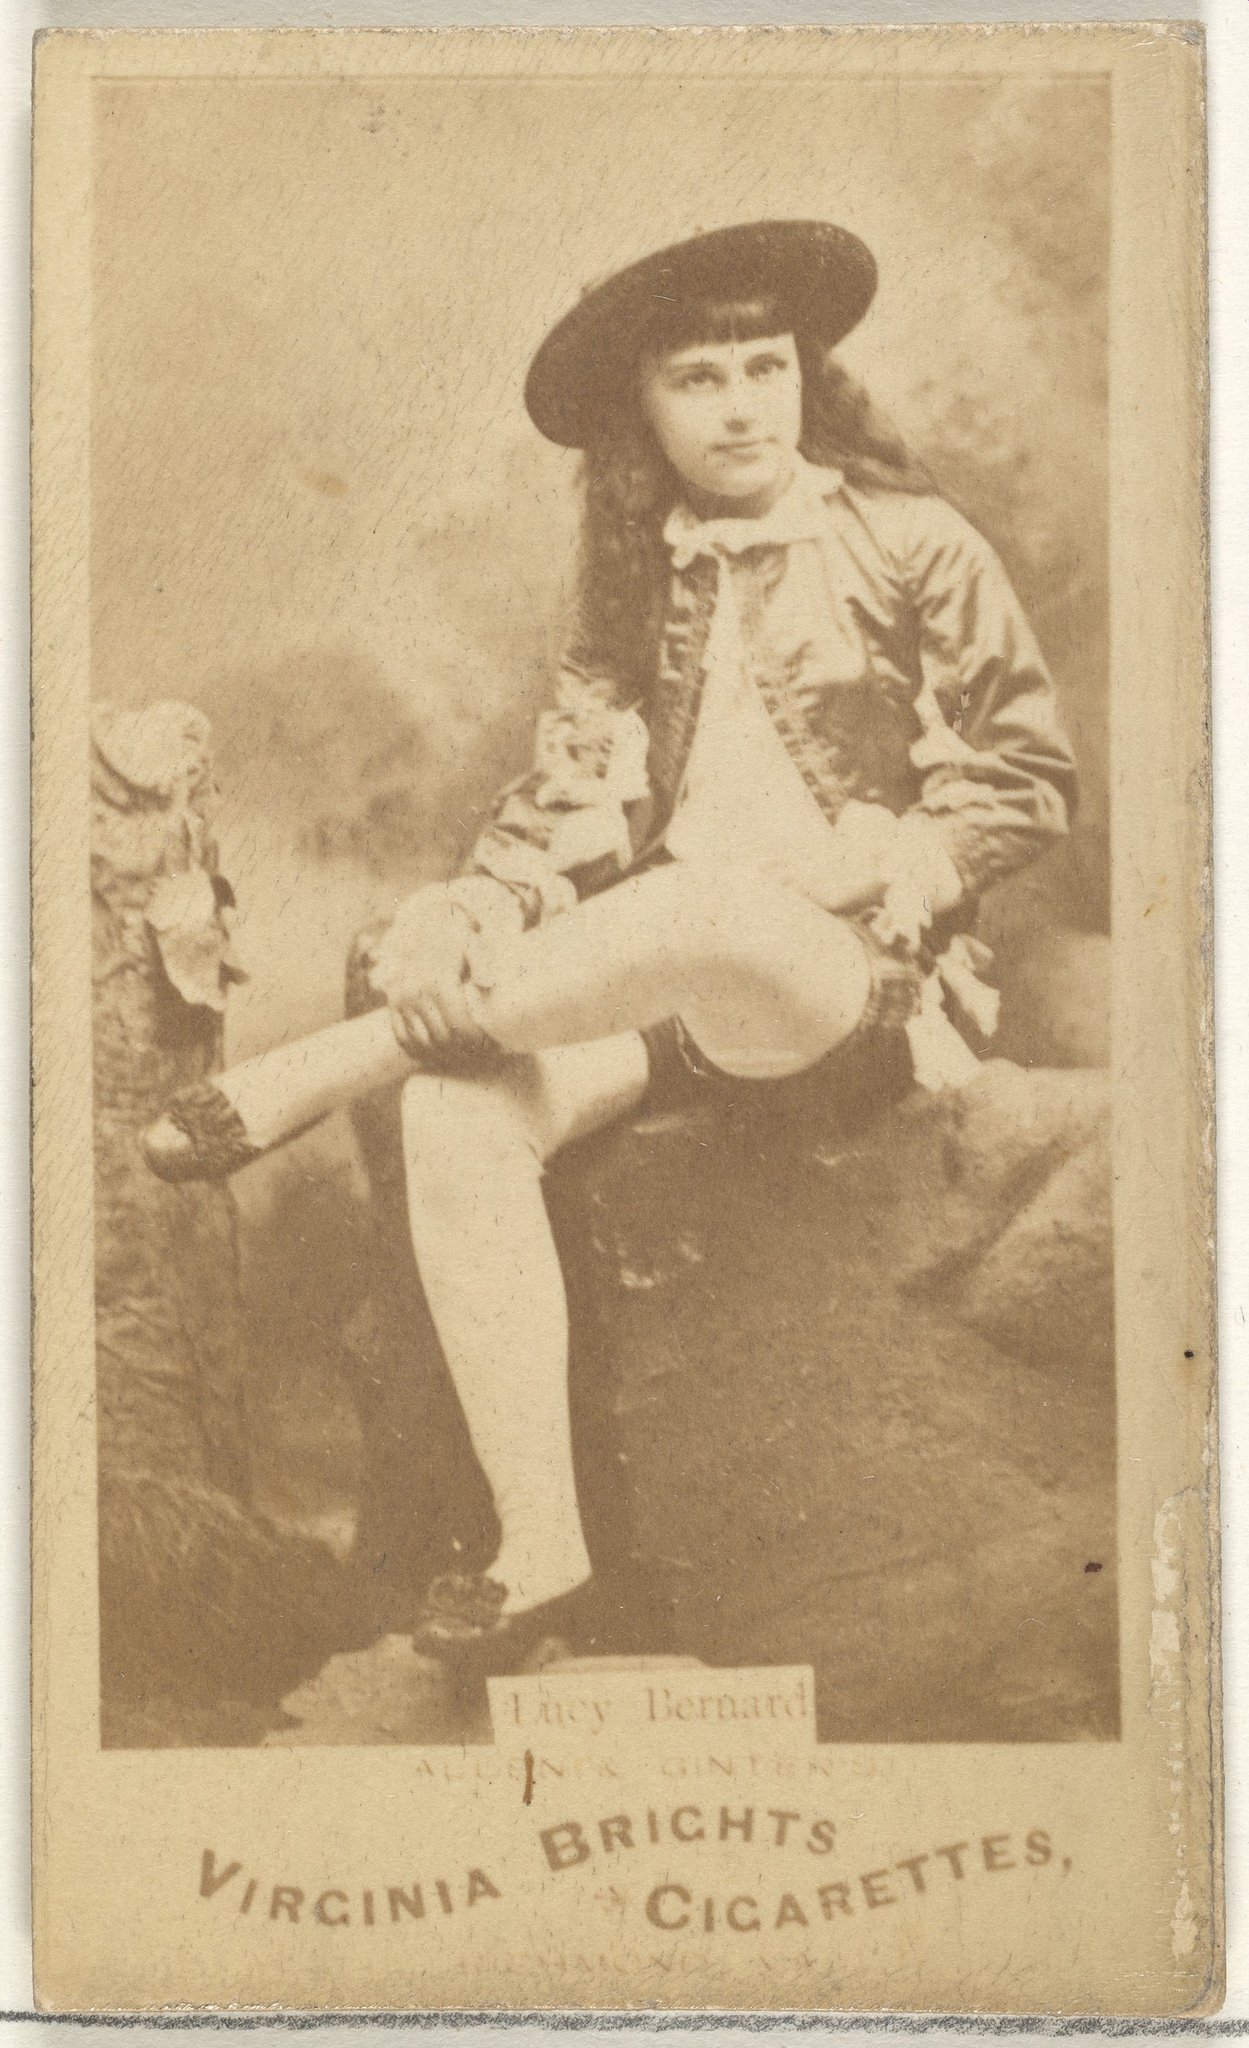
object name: photograph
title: Lucy Bernard, from the Actors and Actresses series (N45, Type 1) for Virginia Brights Cigarettes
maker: allen & ginter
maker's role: publisher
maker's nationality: american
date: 1888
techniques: albumen silver print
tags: portraits,women,actresses